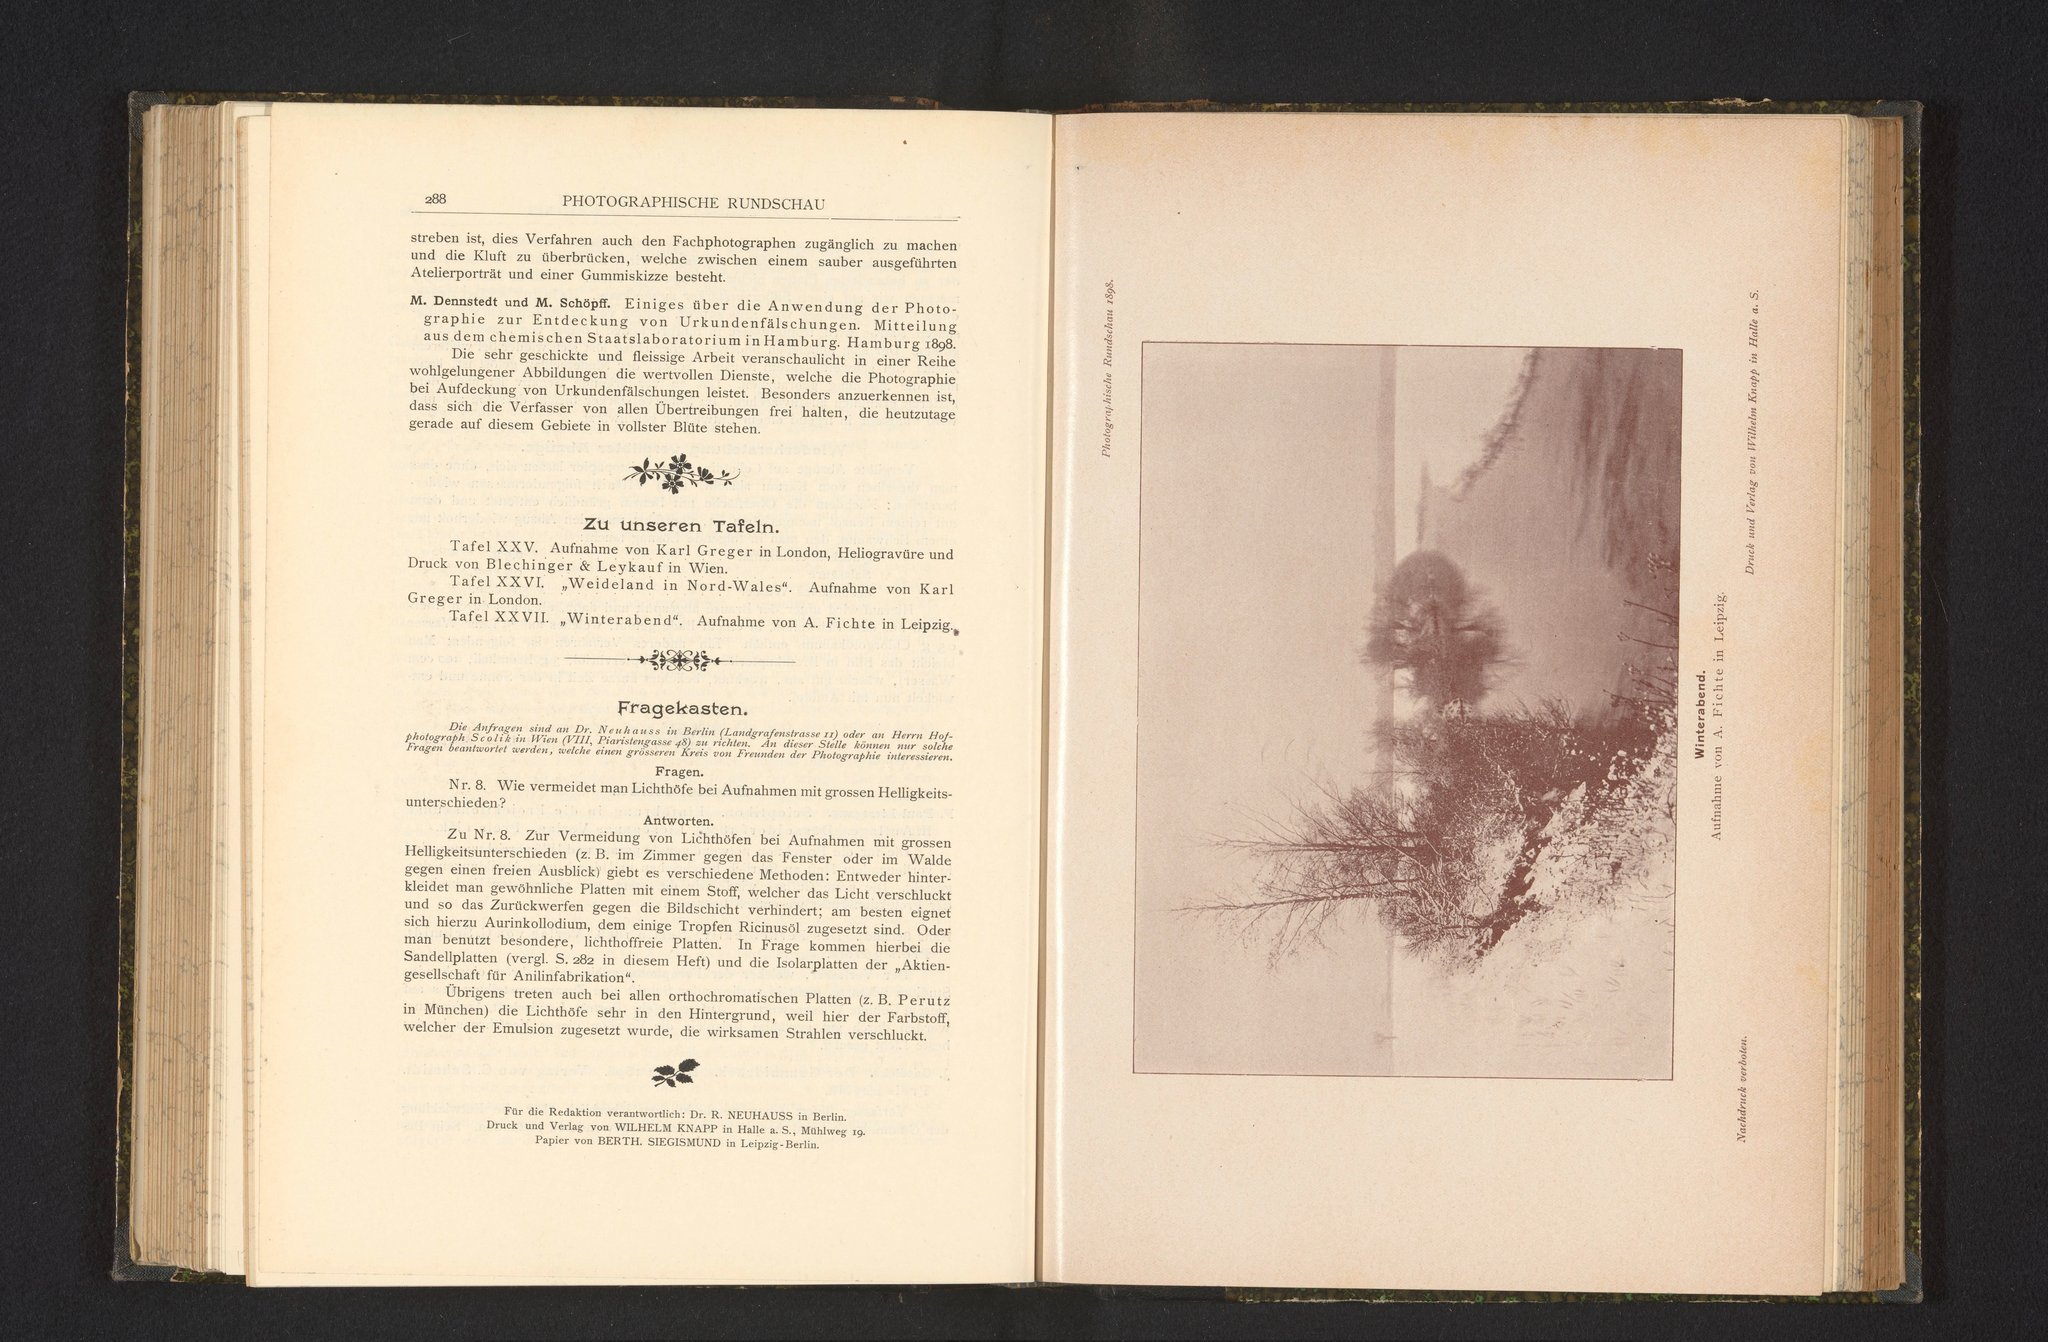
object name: page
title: Winterabend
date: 1893-1898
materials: paper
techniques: autotype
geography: halle an der saale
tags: landscapes, snow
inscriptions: inscription: ‘Aufnahme von A. Fichte in Leipzig.’